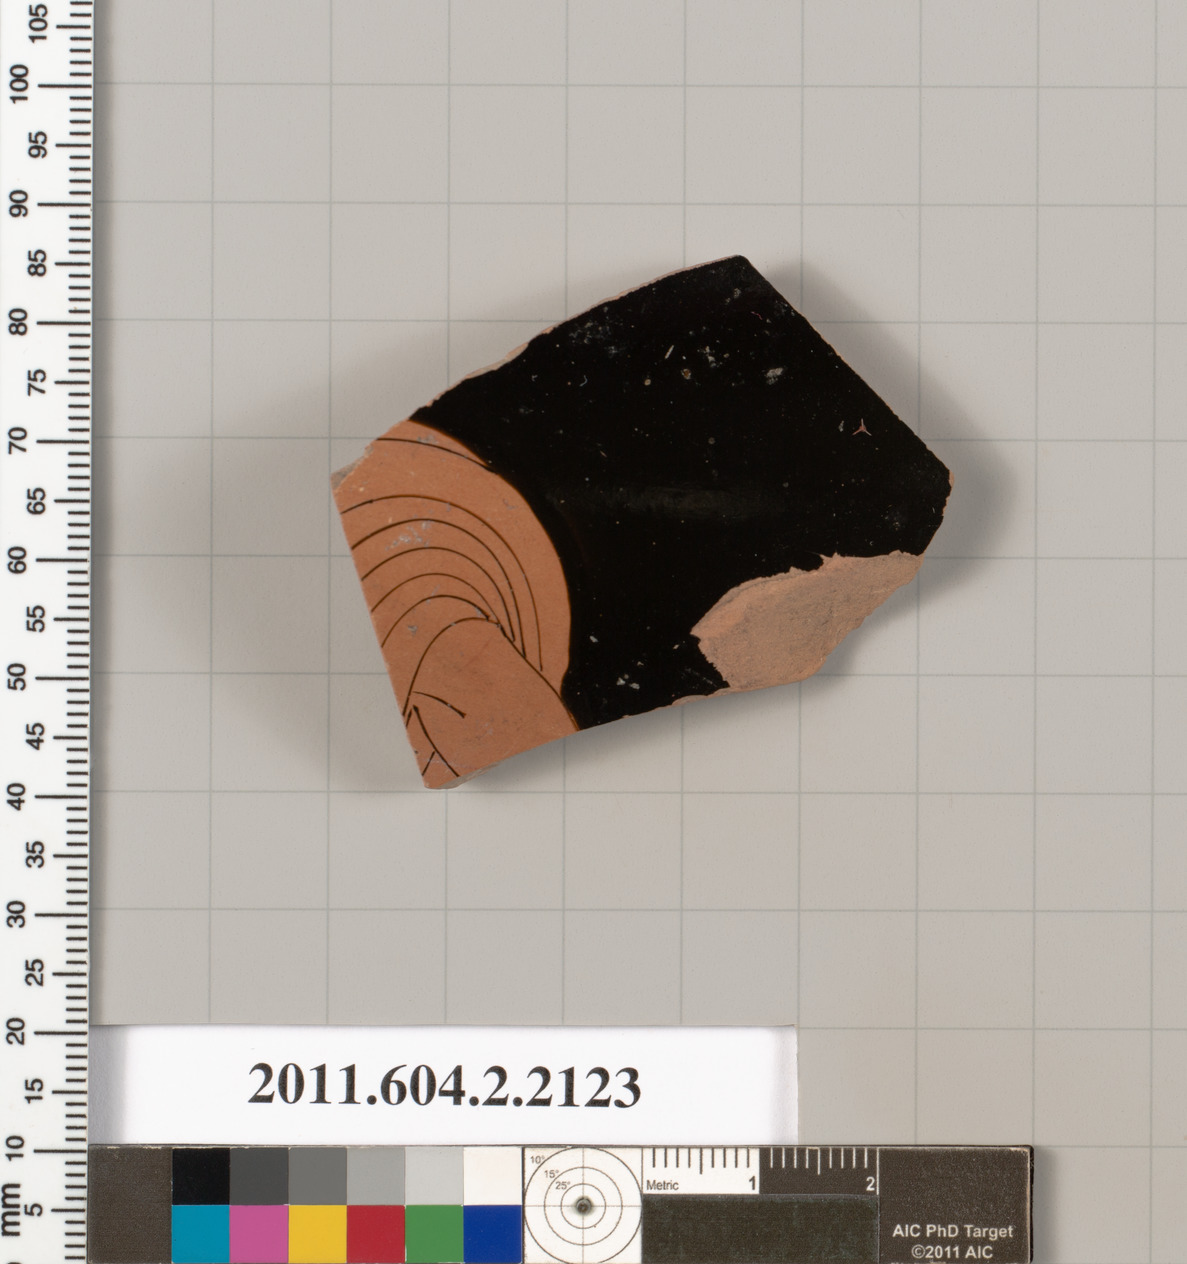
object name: pot fragment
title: Terracotta fragment of a pot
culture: greek, attic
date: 460-440 BCE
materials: terracotta